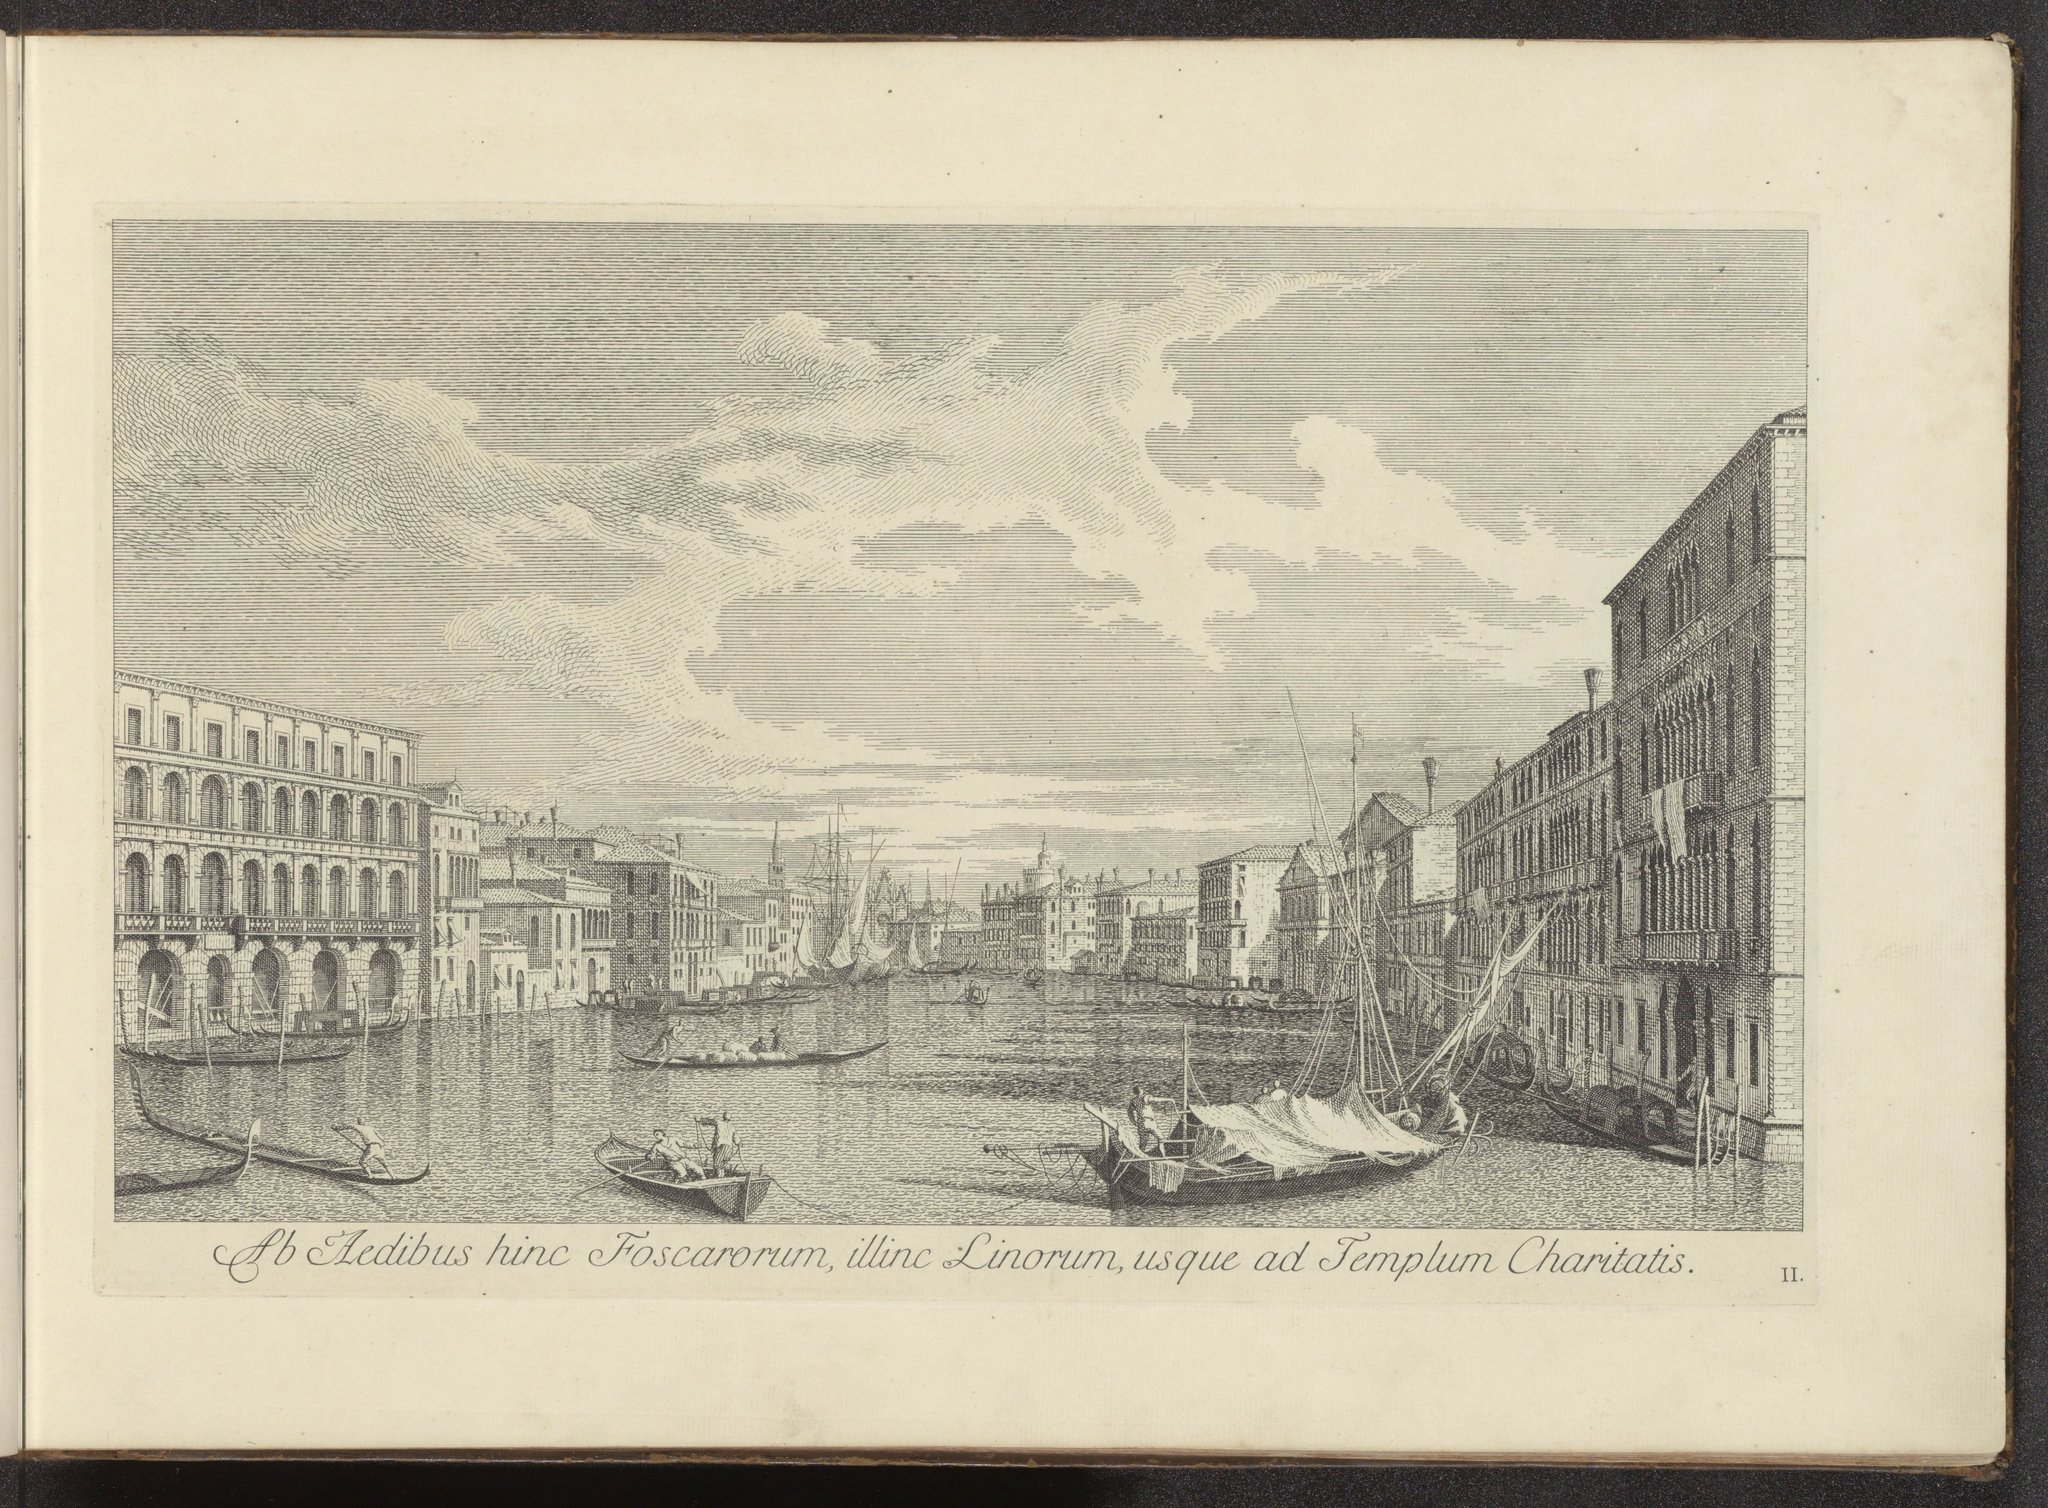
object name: album leaf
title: Urbis Venetiarum prospectus celebriores, ex Antonii Canal tabulis XXXVIII aere expressi ab Antonio Vissentini in partes tres distributi. pars prima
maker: antonio visentini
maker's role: draughtsman, print maker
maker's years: 1688-1782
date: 1742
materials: paper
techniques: etching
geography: venice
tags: city-view, and landscape with man-made constructions, canal